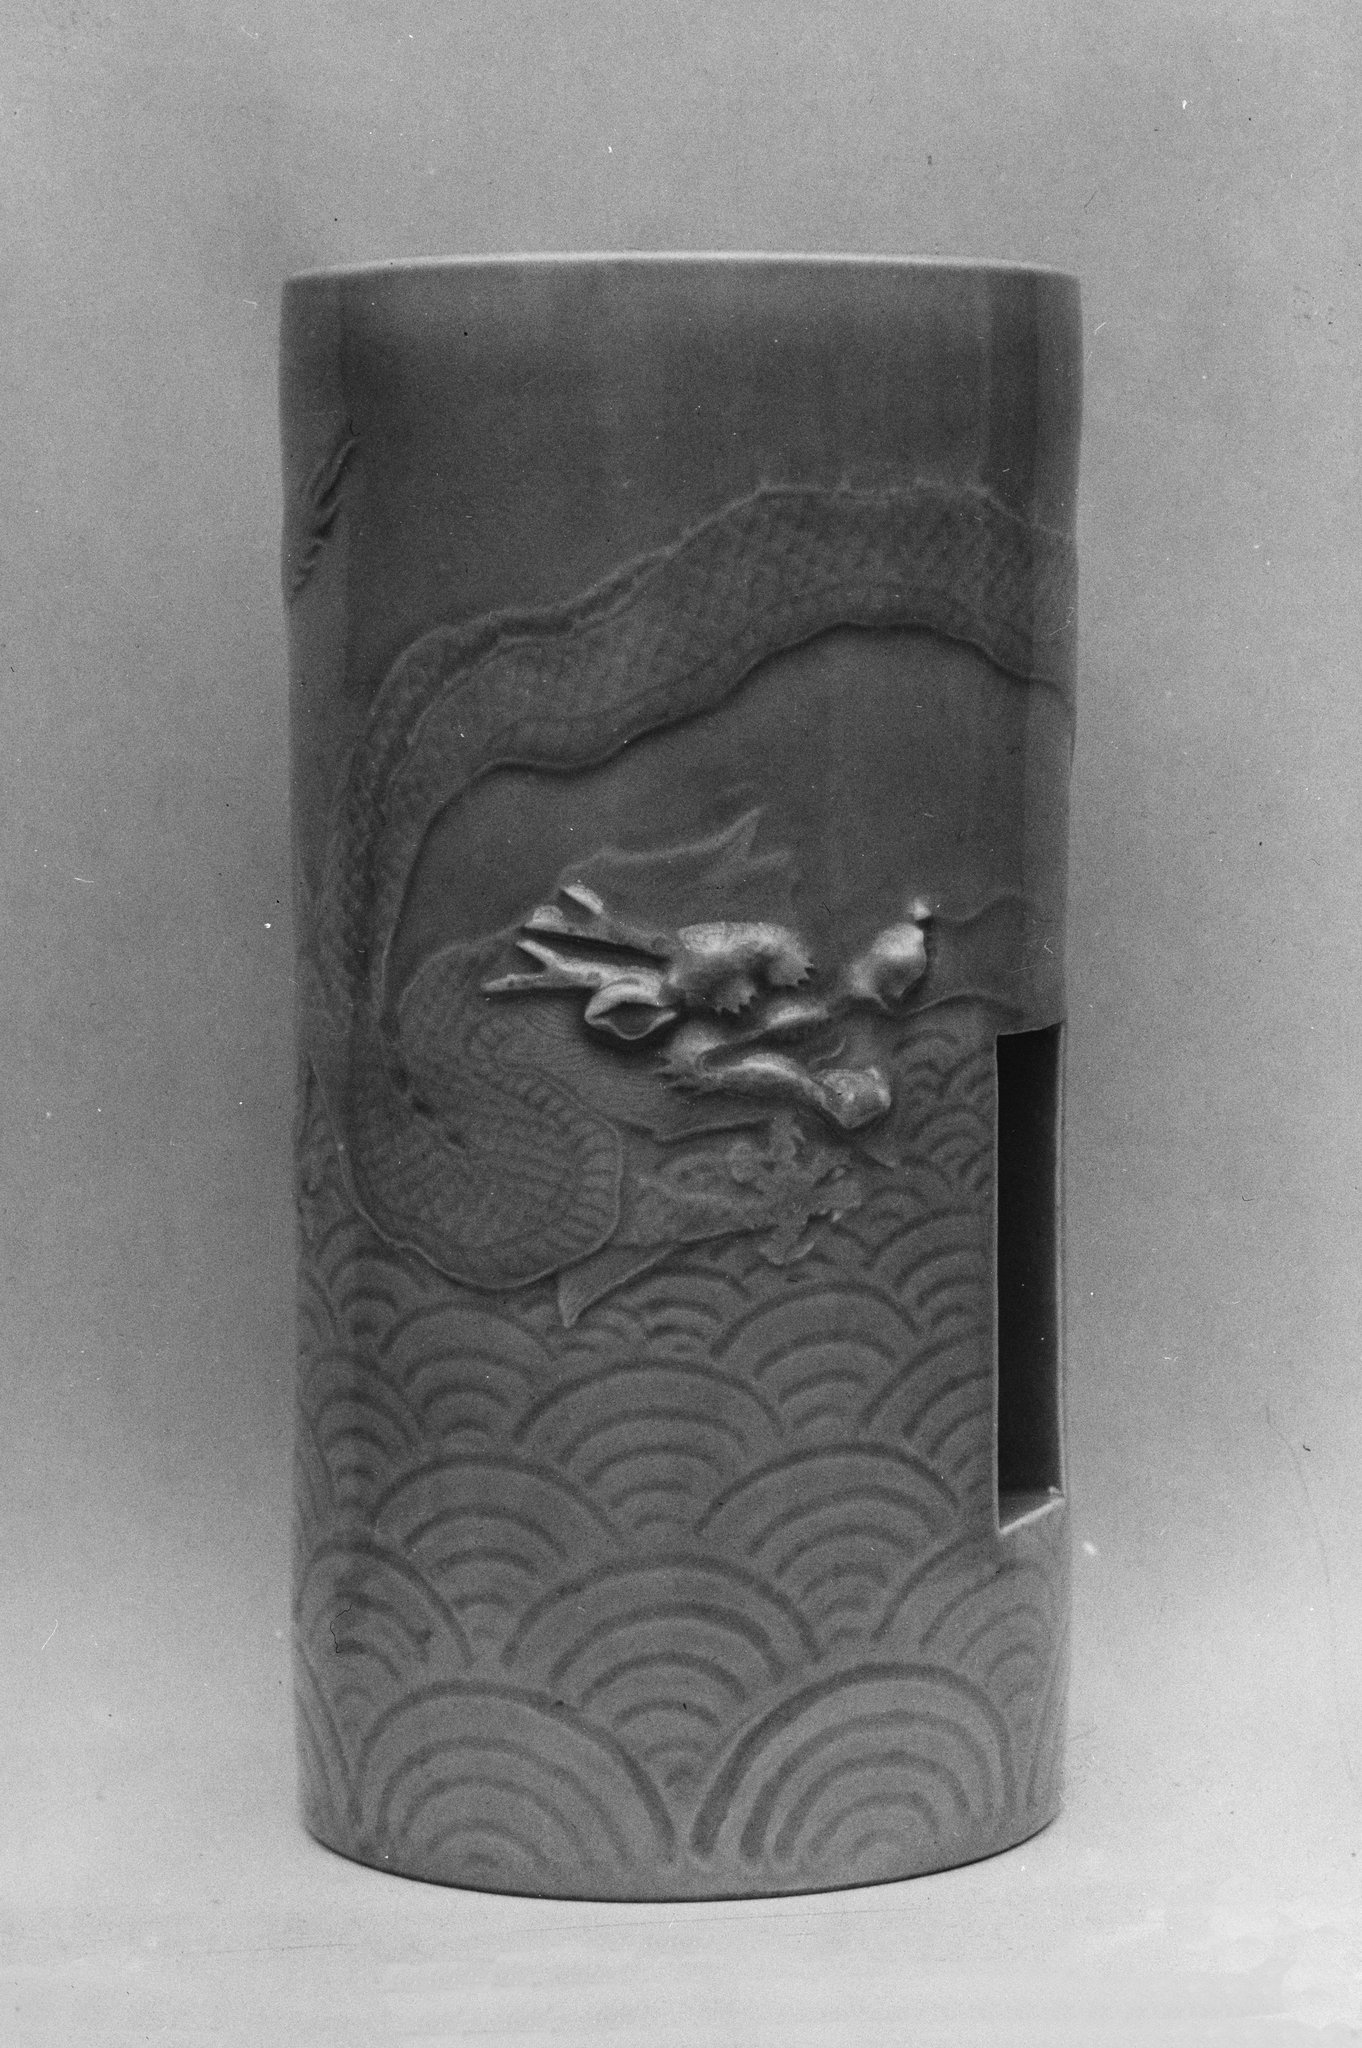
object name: vase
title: Vase for a Pillar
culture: japanese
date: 1801-1900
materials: ceramic glaze, glaze, porcelain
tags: dragons